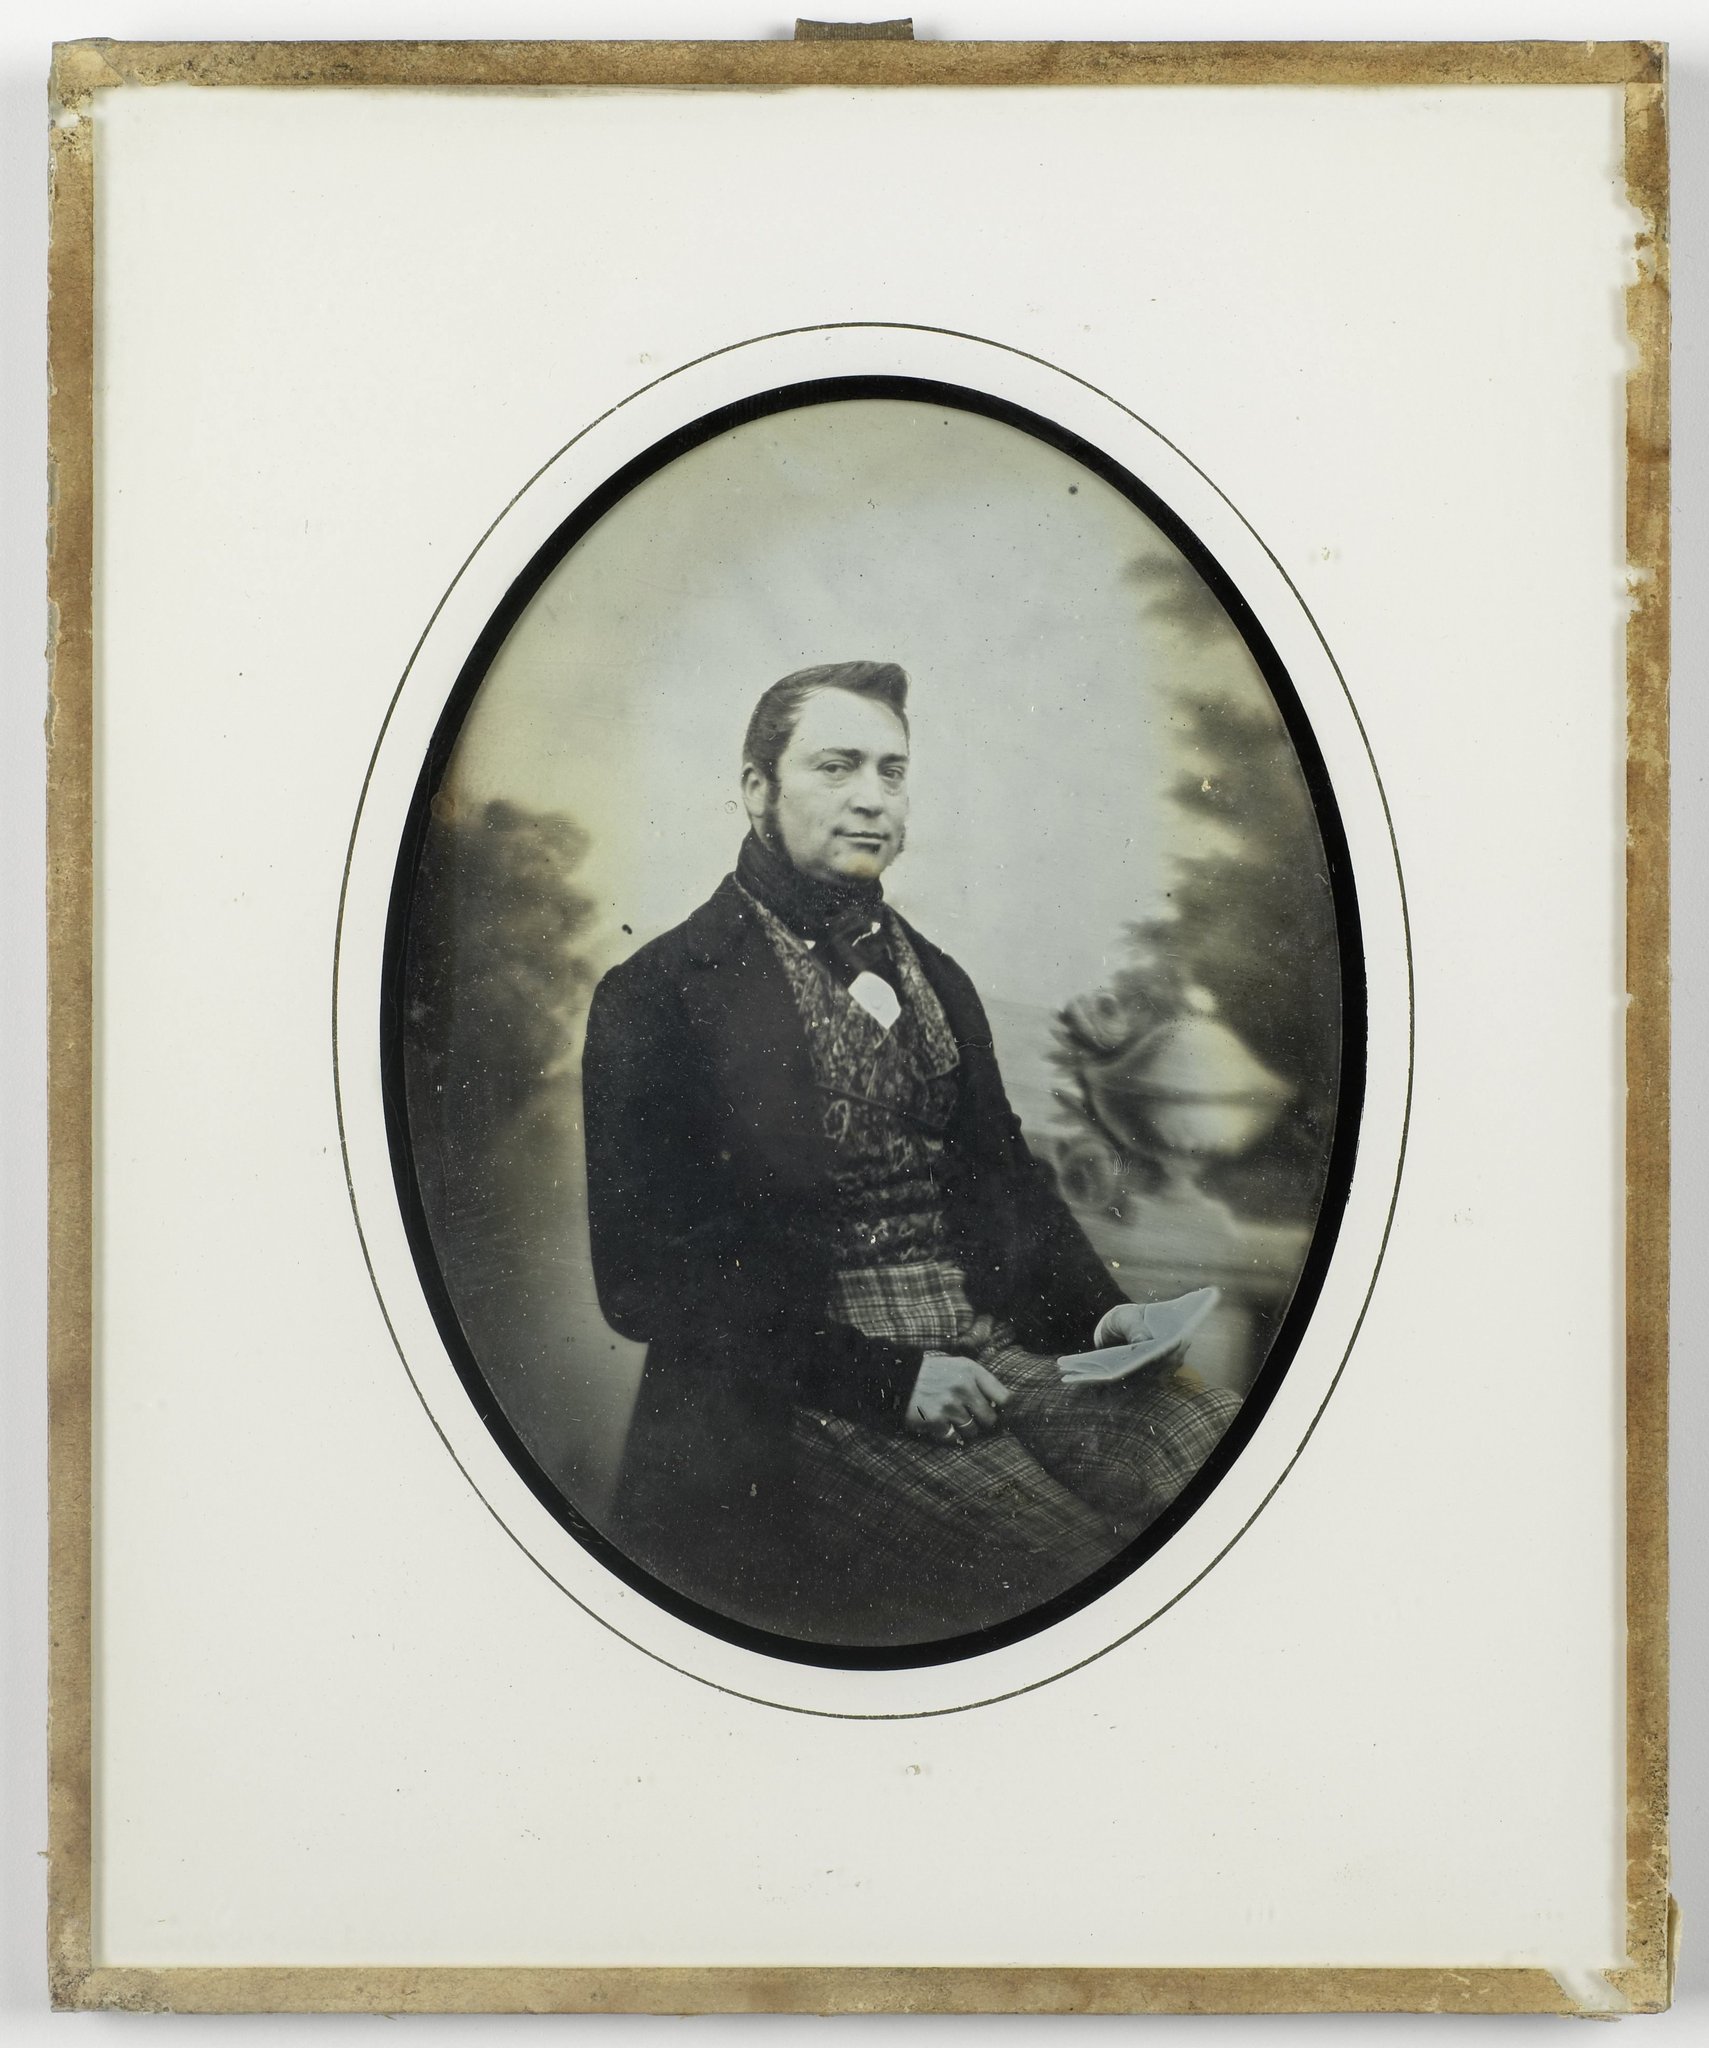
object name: photograph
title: Portret van Paul Cesar Lagache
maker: m. finck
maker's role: fotograaf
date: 1843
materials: copper, glass, paper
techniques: daguerreotype, hand coloring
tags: adult man, historical persons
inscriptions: inscription: ‘[...] 1843/ Portraits au Dag./ [...]/ Par M. Finck/ [...]/ Strasbourg’